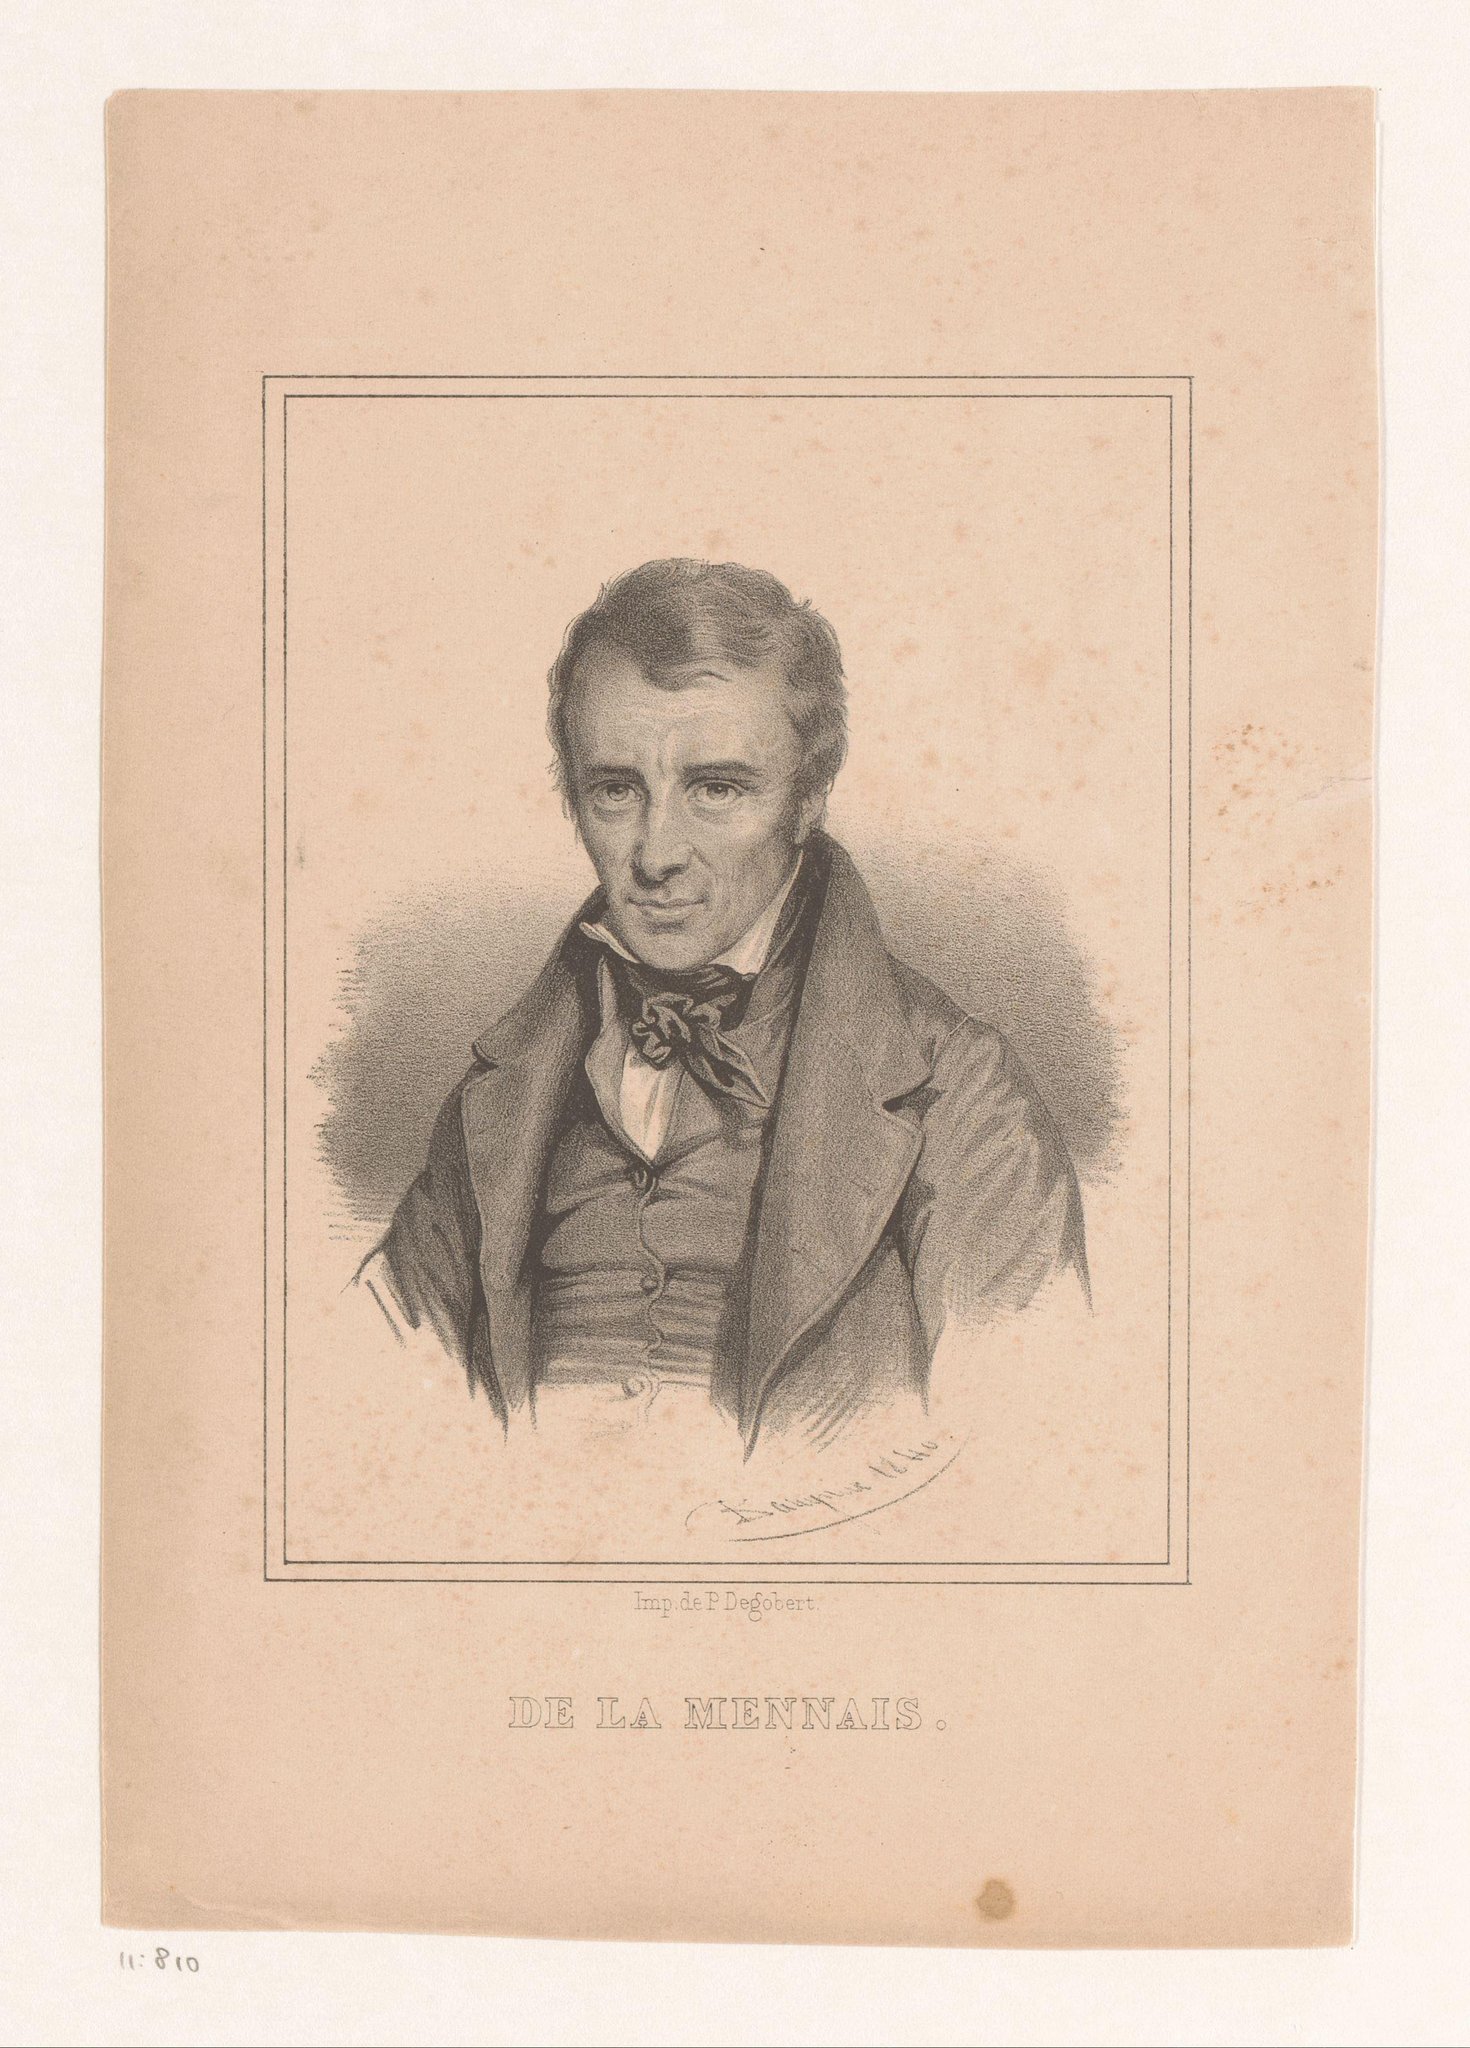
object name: print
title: De la Mennais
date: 1840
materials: paper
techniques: lithograph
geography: brussels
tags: paris, adult man, historical persons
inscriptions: collector's mark: Lugt 2228